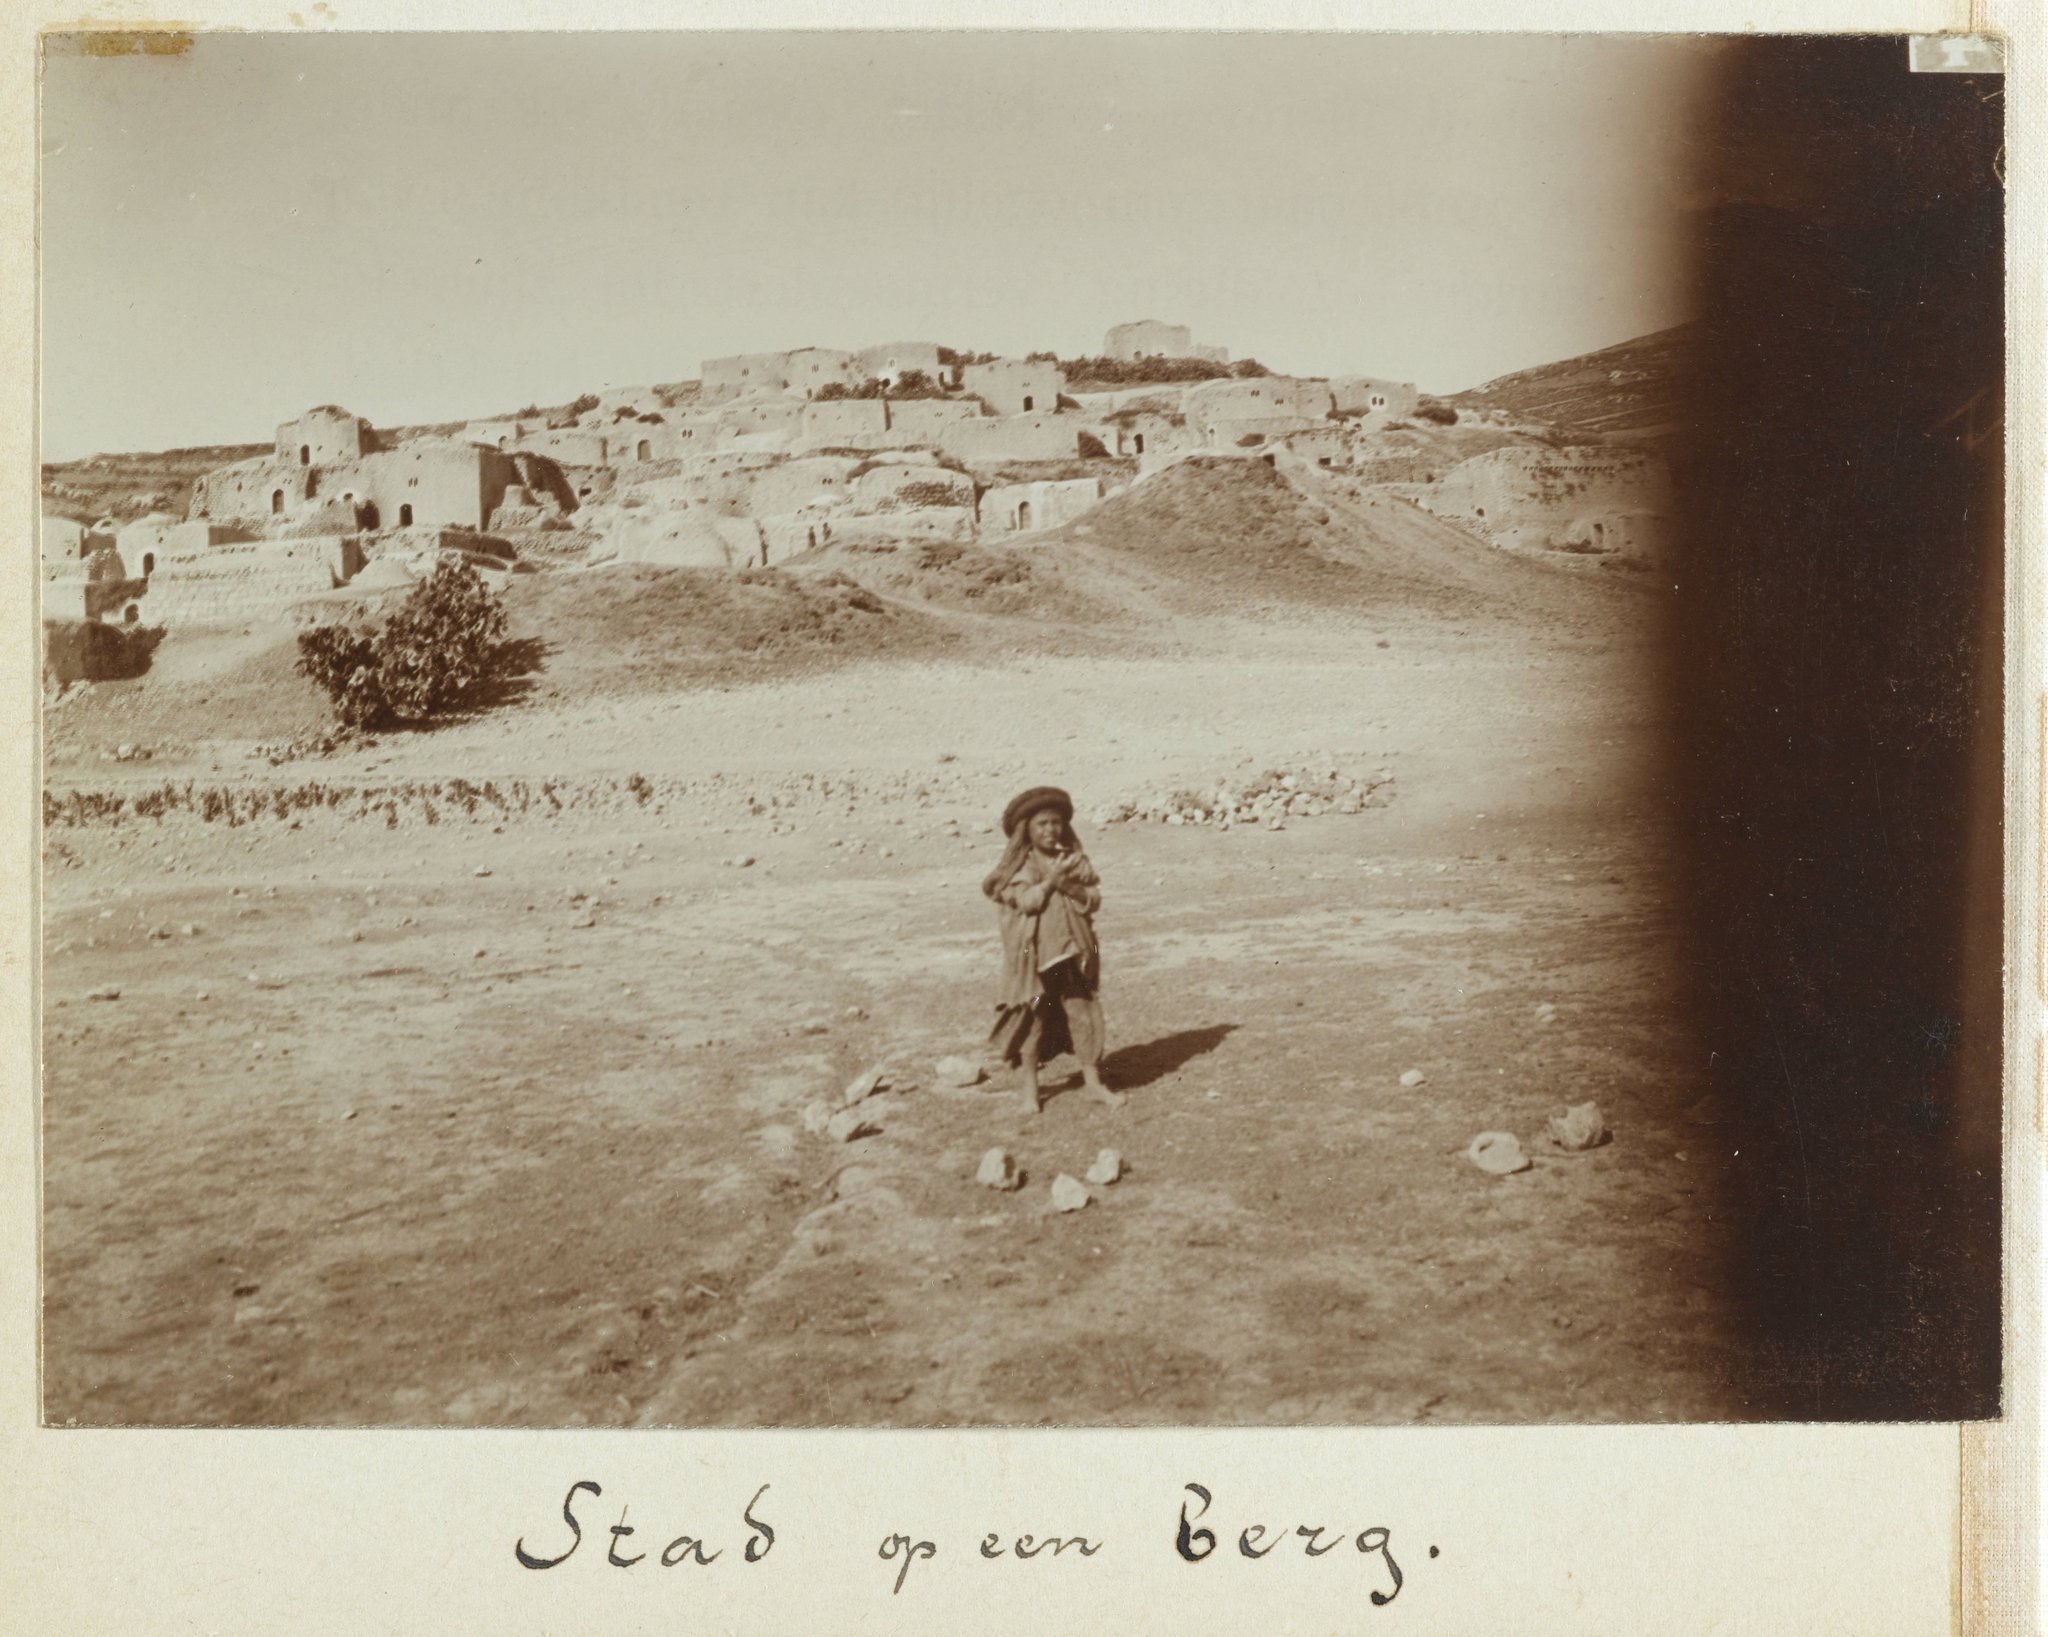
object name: page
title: Stad op een berg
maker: johannes lodewijk heldring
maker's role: fotograaf, predikant, schrijver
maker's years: 1852-1923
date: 1898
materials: paper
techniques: collodion silver print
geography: israel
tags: city-view in general; 'veduta', child